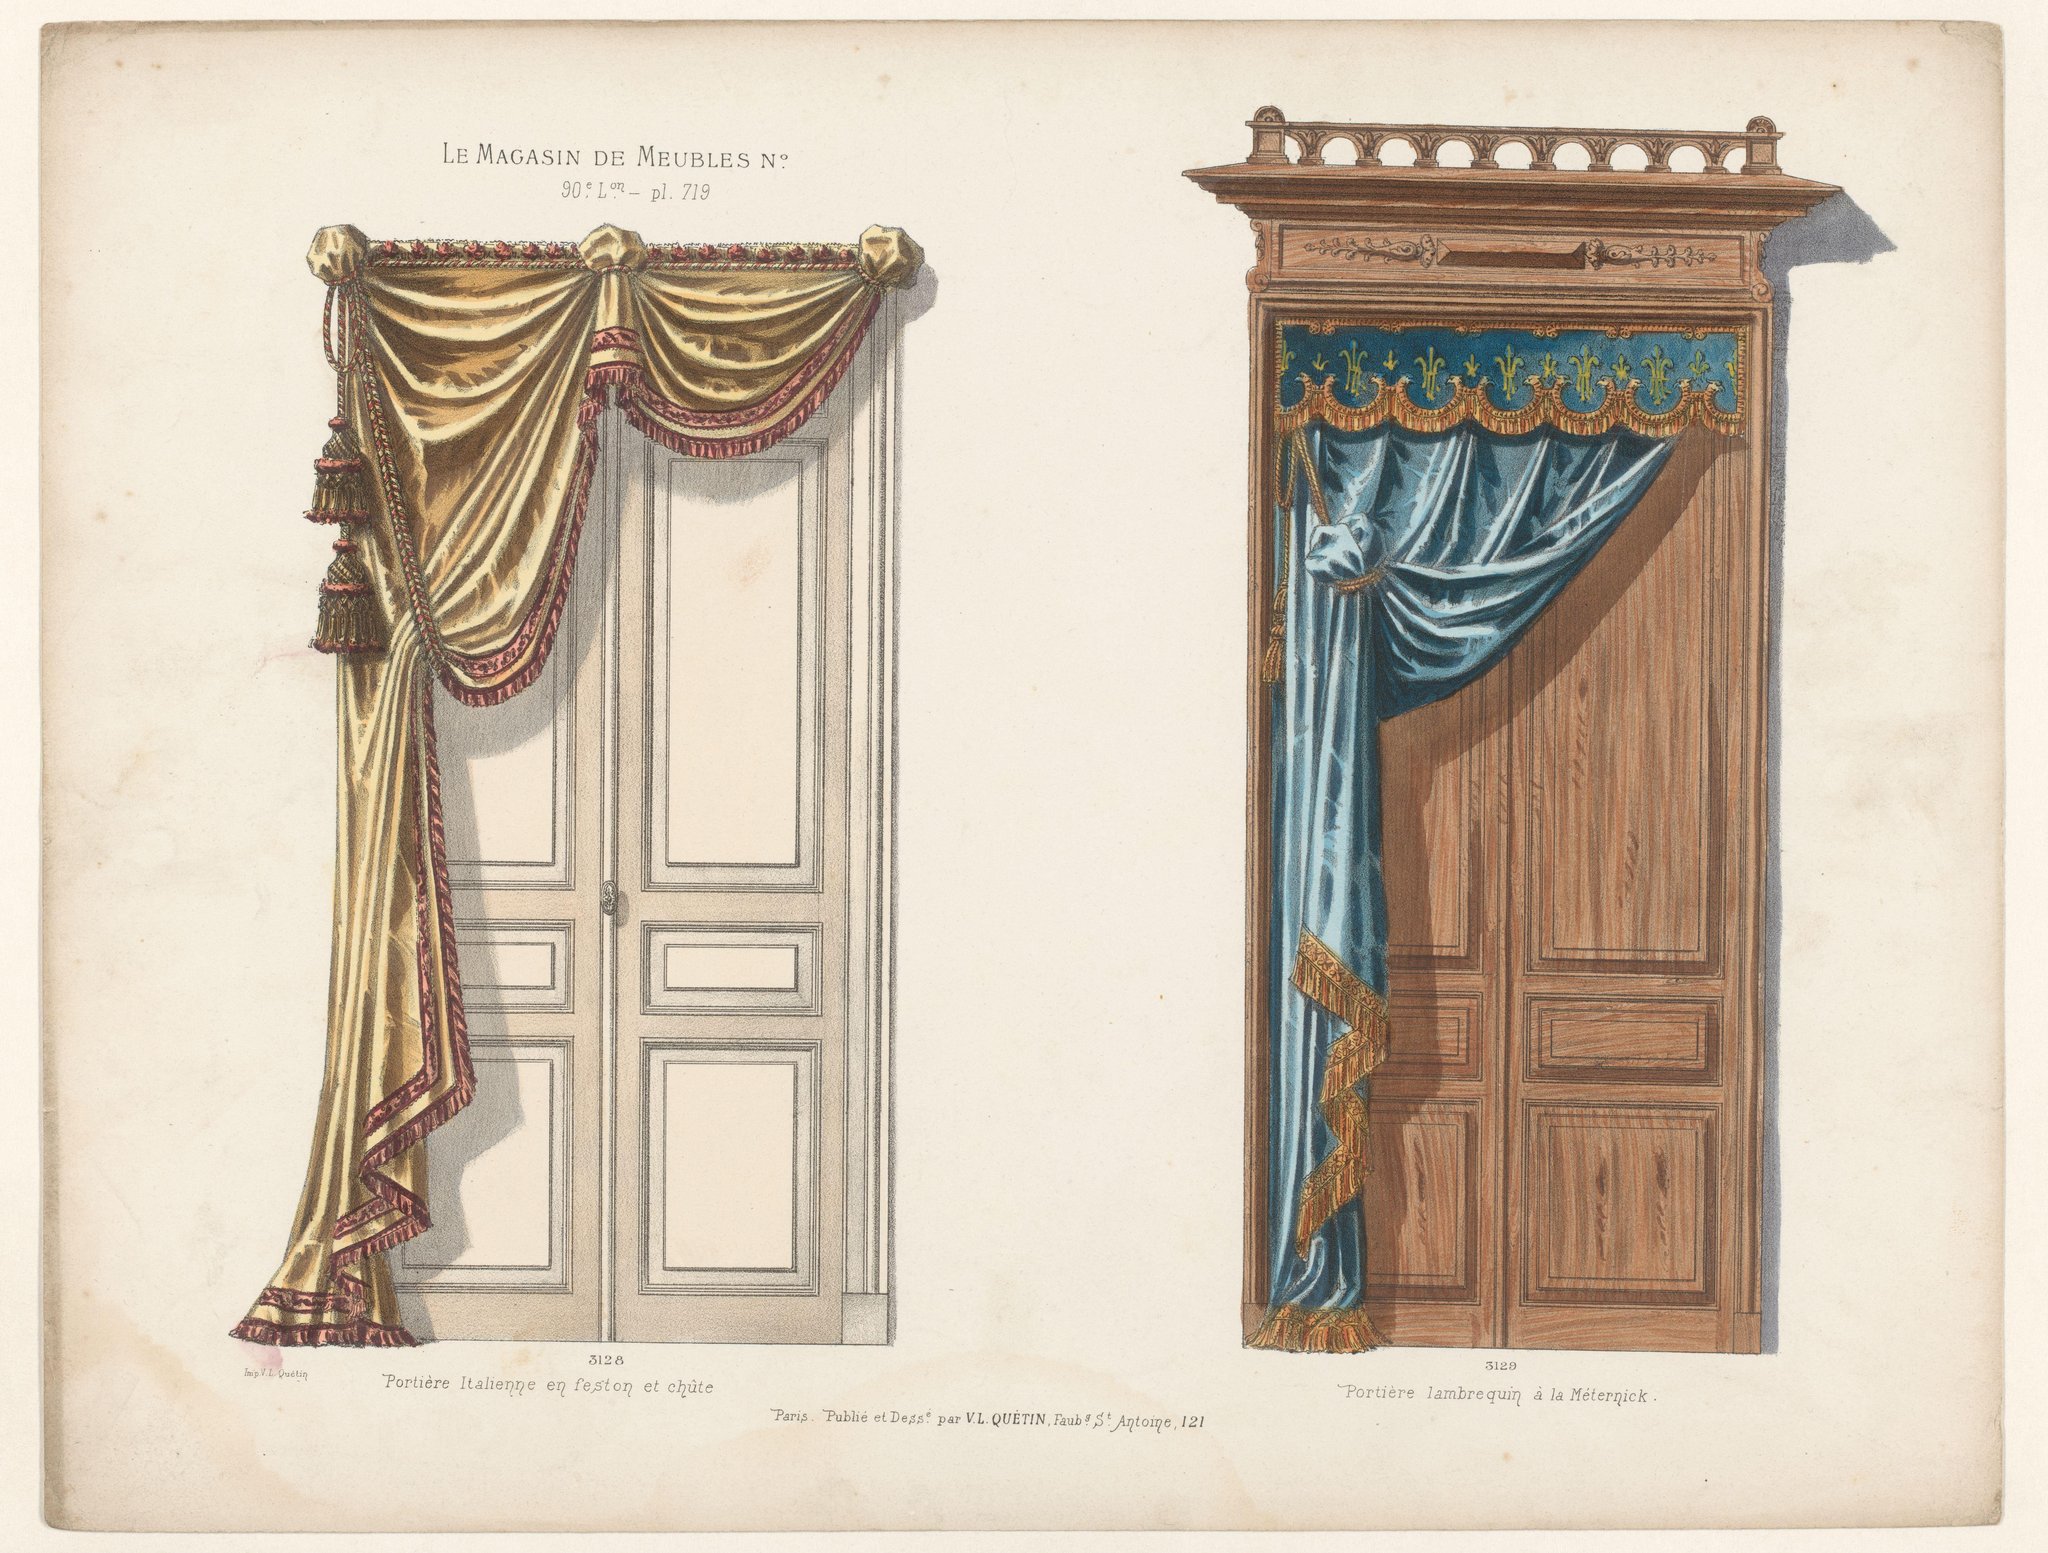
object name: print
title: Twee deuren met gordijnen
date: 1878-1904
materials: paper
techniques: hand coloring, lithograph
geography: paris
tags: door, hangings and drapery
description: Twee deuren met gedrapeerde gordijnen. Prent uit 90e Livraison.